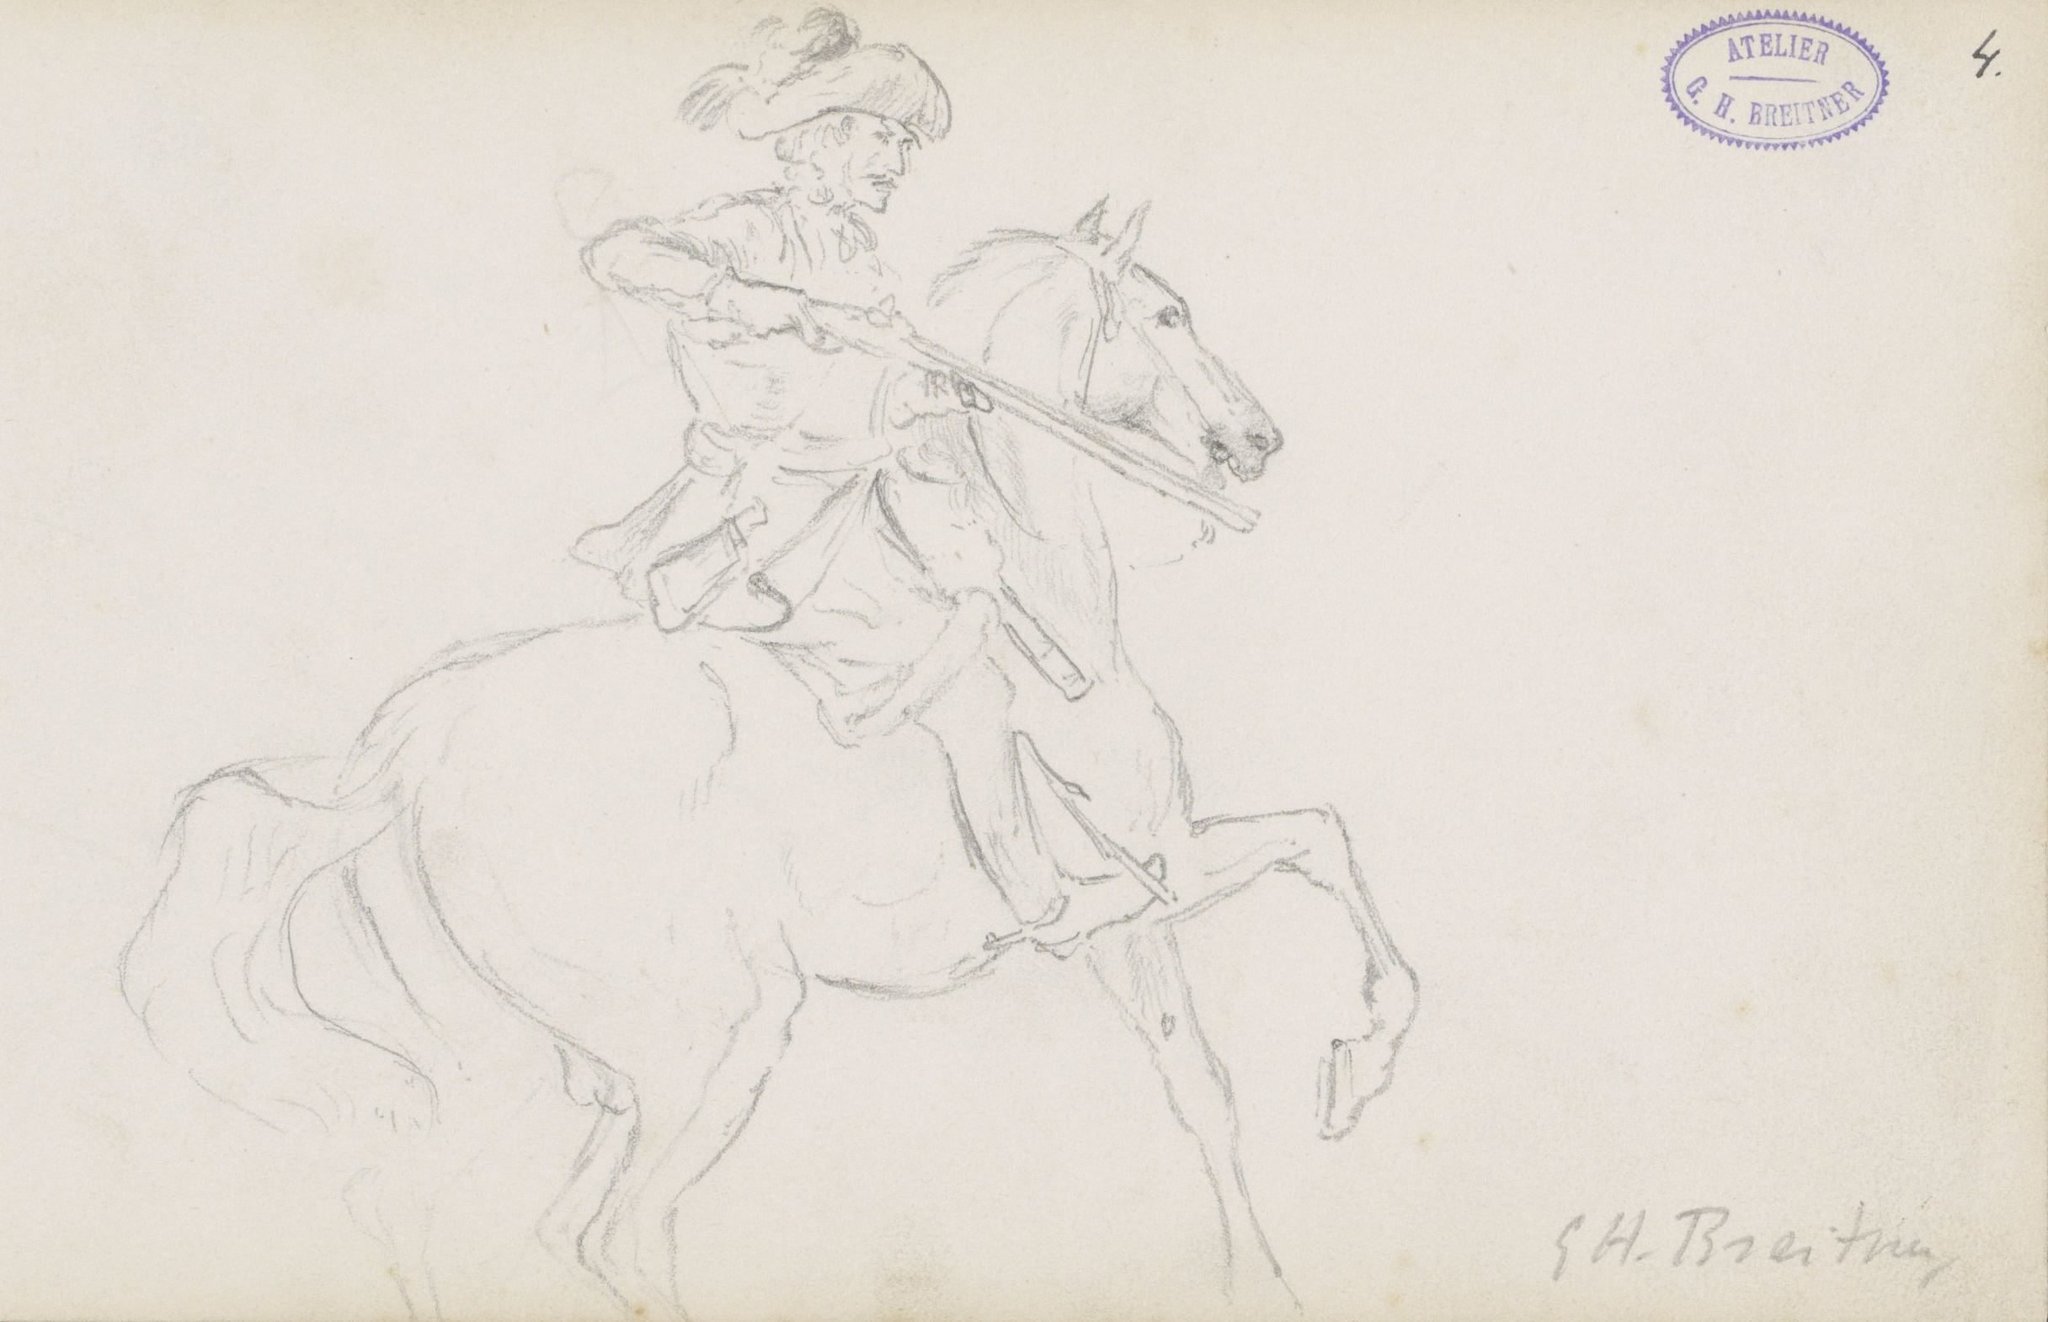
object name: drawing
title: Ruiter met musket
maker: george hendrik breitner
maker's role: draughtsman, painter, print maker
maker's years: 1857-1923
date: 1874-1876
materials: paper, pencil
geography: rotterdam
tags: riding a horse, ass, or mule; rider, horseman, firearms: rifle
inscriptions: workshop stamp: Lugt 291d, collector's mark: Lugt 2228, signature: ‘G.H. Breitner’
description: Deze tekening heeft oorspronkelijk als blad 4 deel uitgemaakt van een schetsboek. Zie voor dit schetsboek het gerelateerd object.